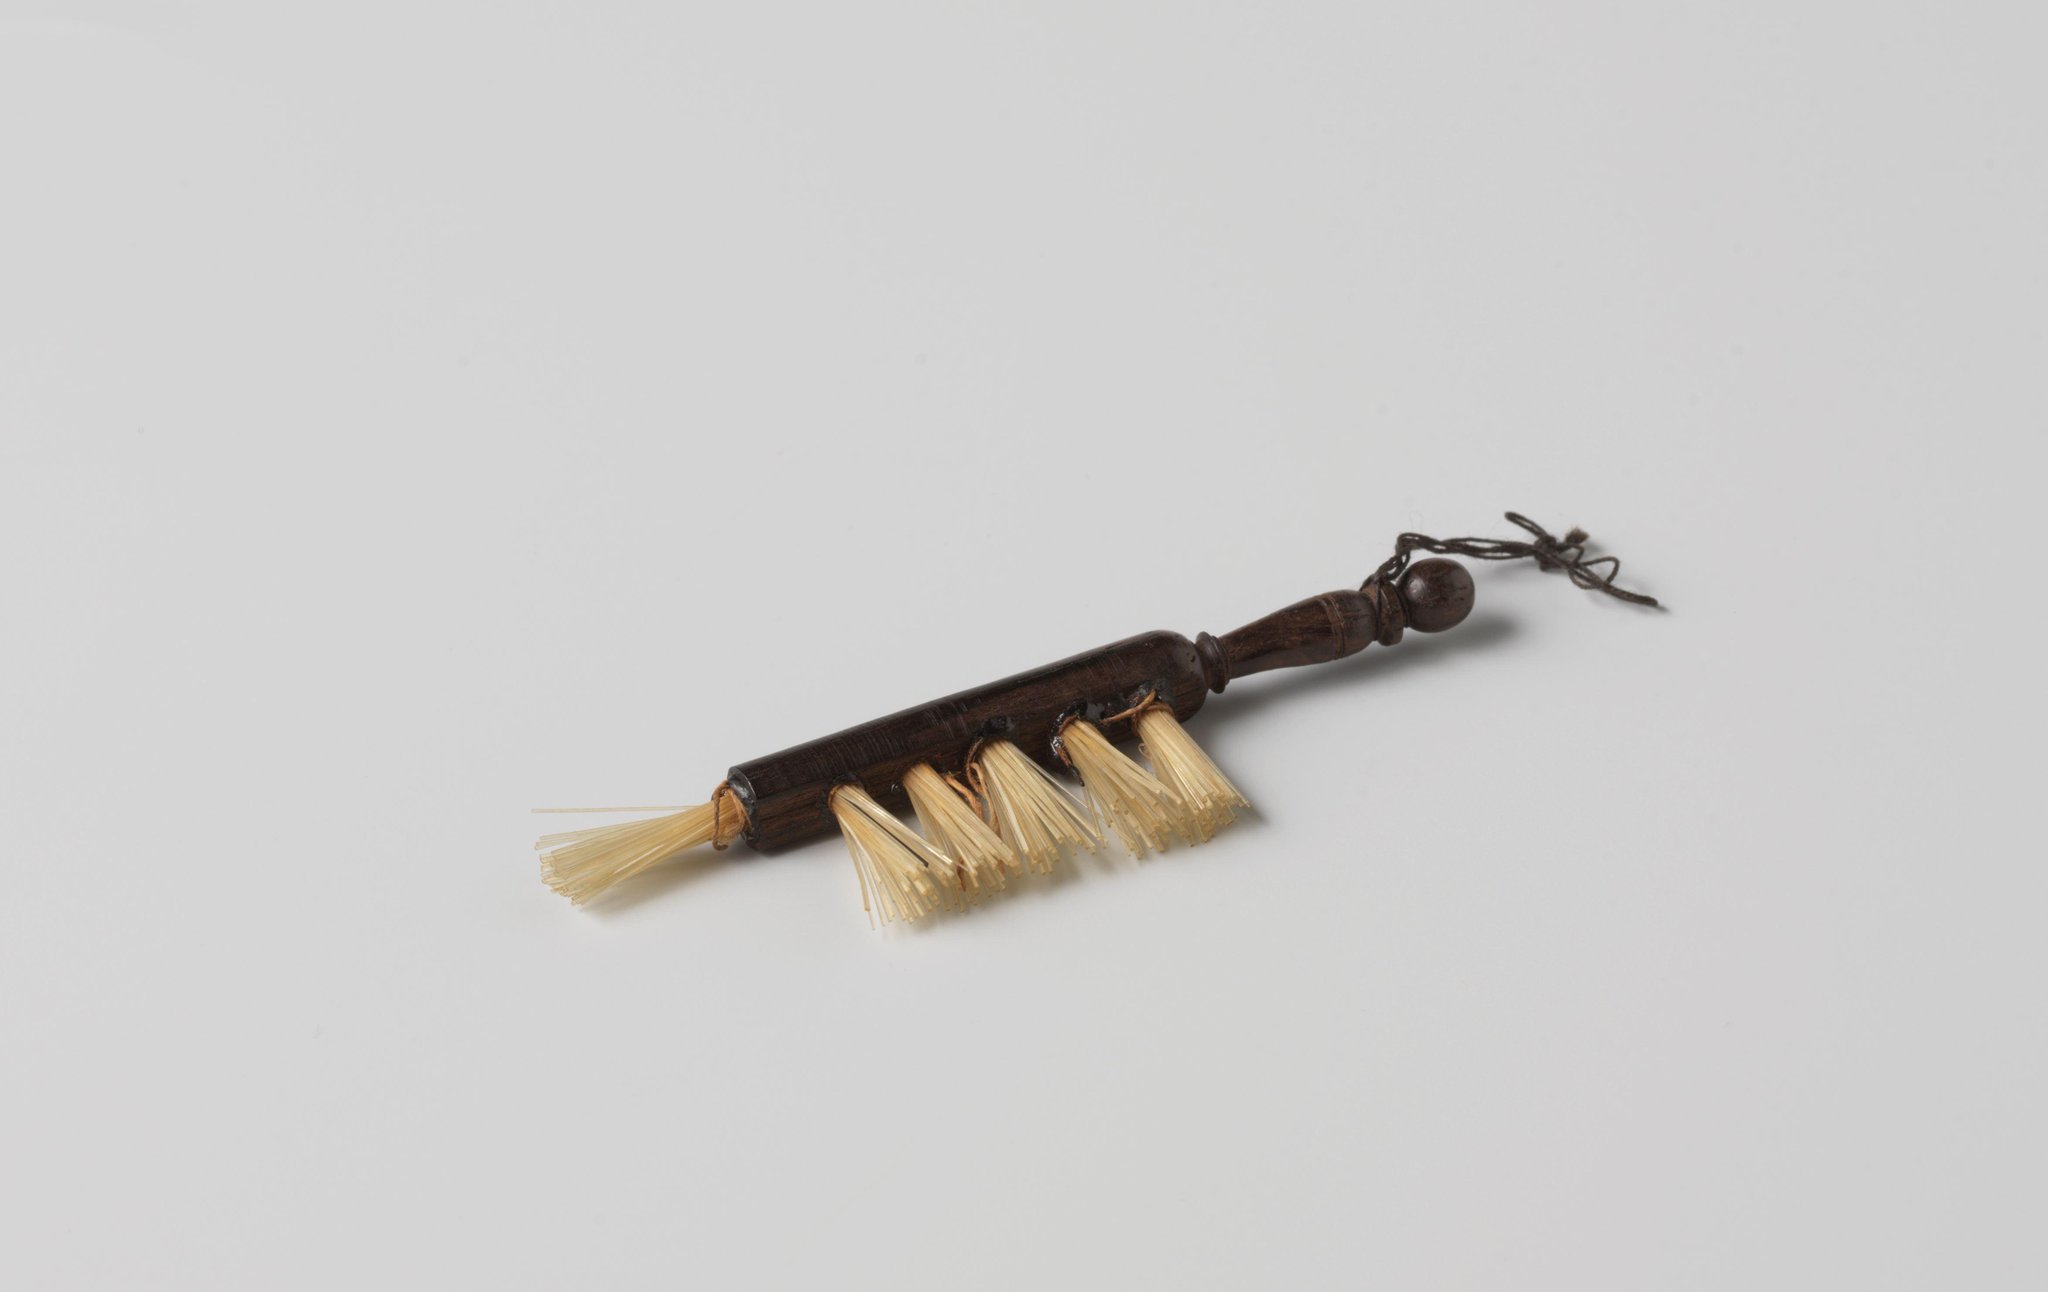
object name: whisk broom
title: Stoffer met haren aan de onderzijde en aan de korte zijde, met ronde geprofileerde steel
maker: Anonymous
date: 1675-1699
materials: wood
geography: amsterdam